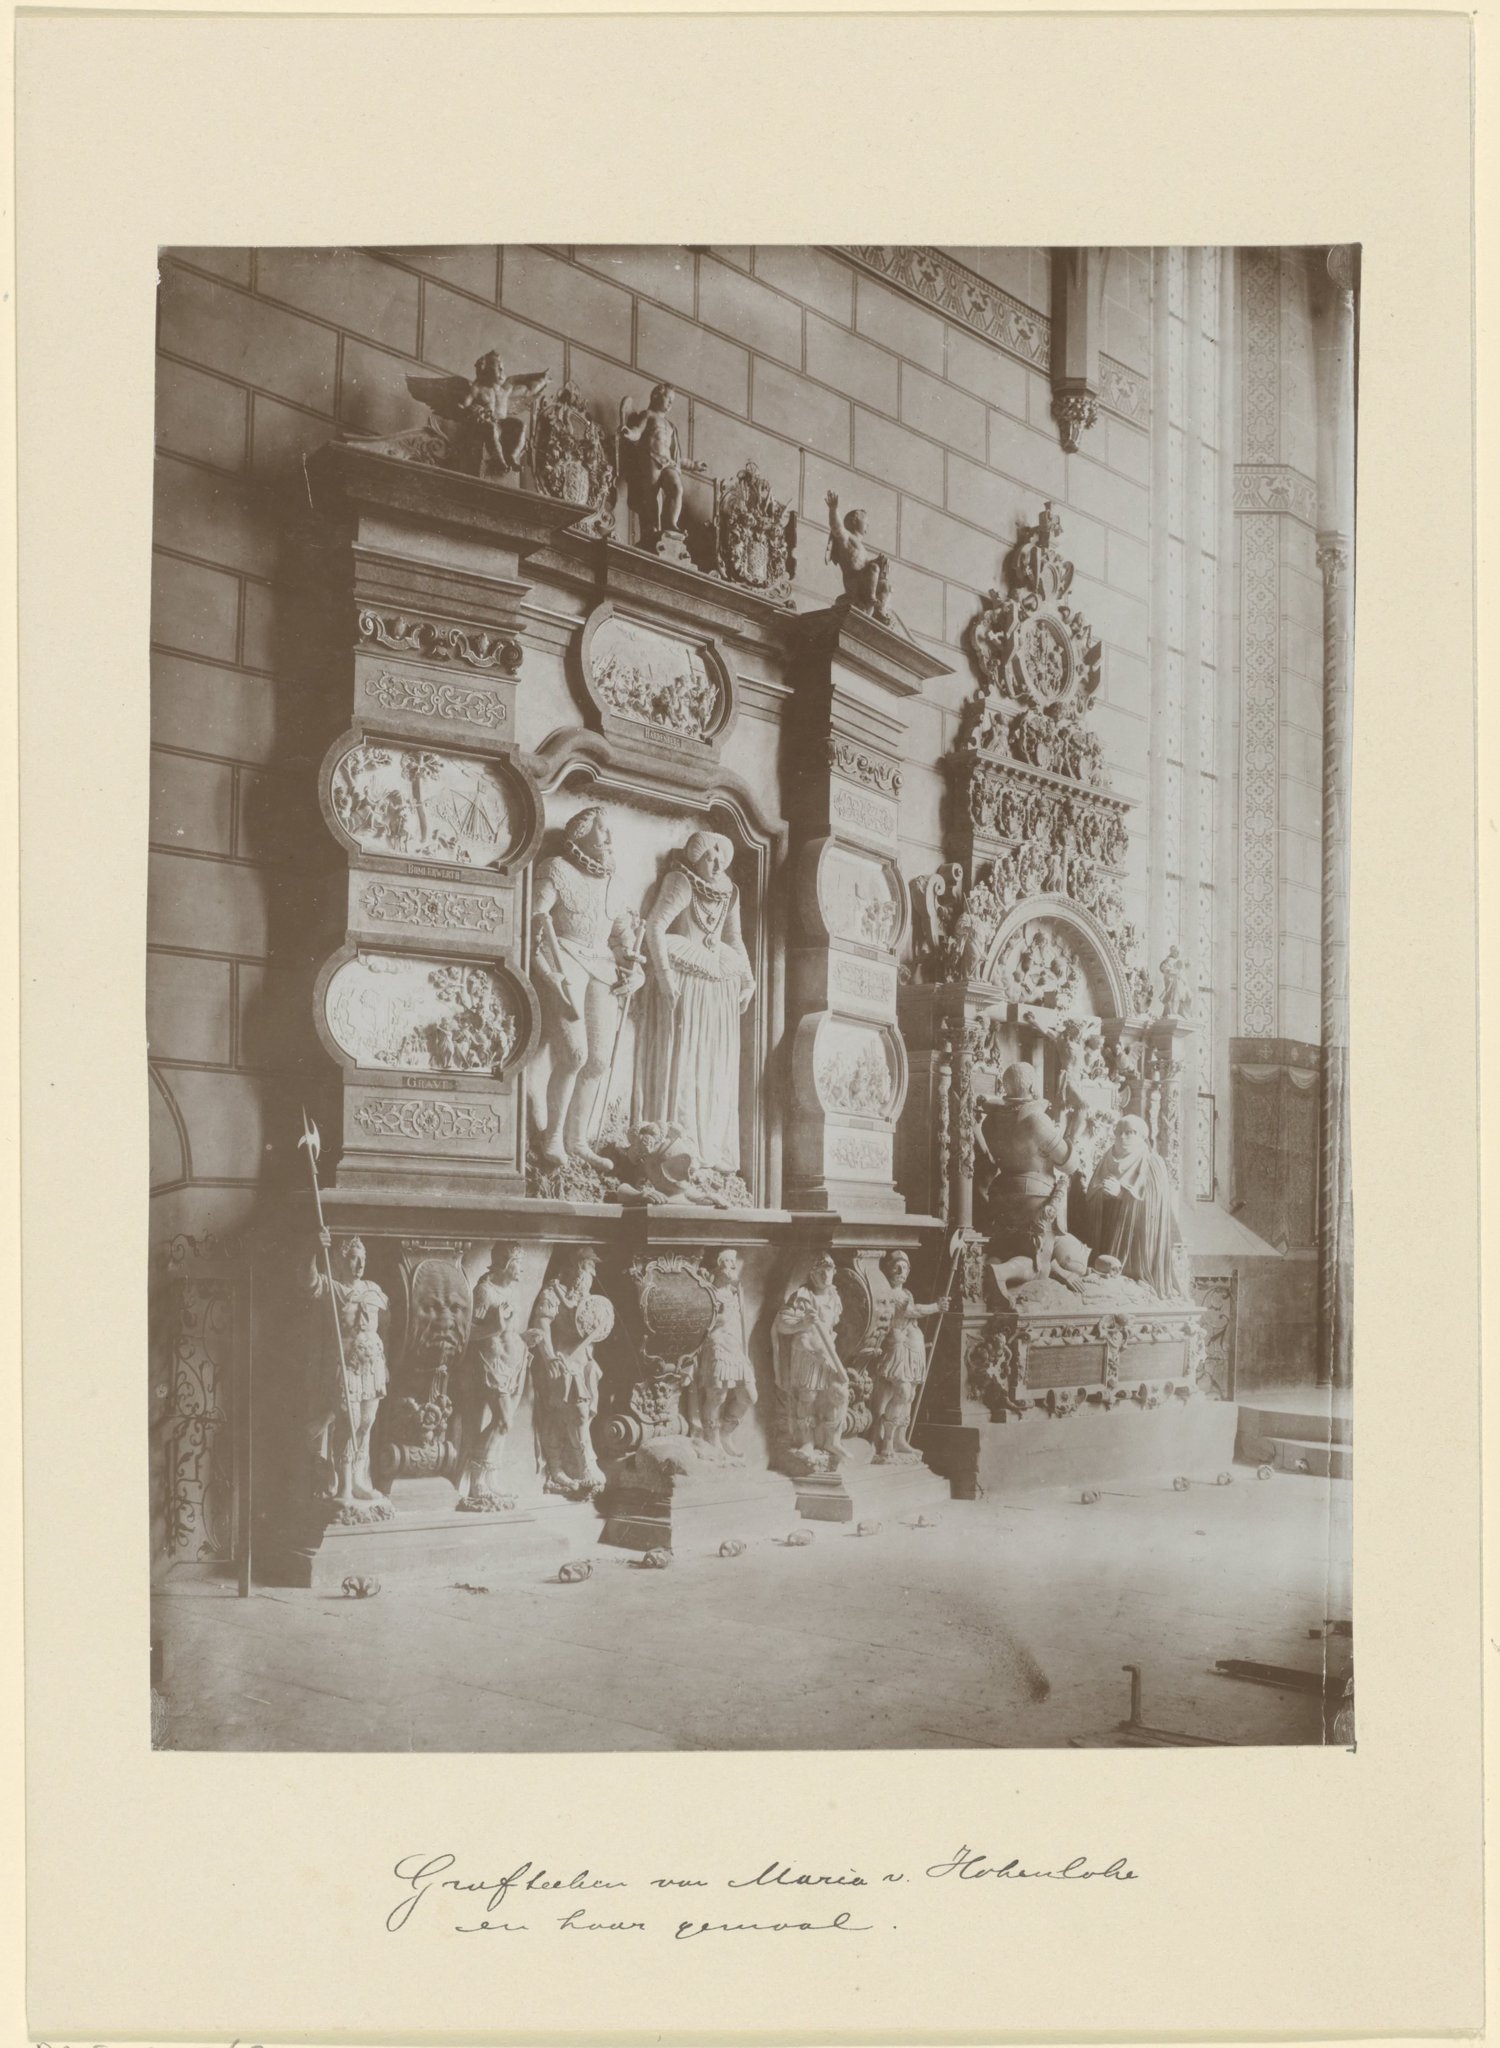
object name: photograph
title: Grafmonument voor Maria, prinses van Oranje, en Filips, graaf van Hohenlohe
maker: Anonymous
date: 1850-1930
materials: photographic support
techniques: collodion silver print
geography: netherlands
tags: buren, grave-building, monumental tomb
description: Grafmonument voor Maria en Filips in de Sint Peter en Paul Kerk te Öhringen, overleden op 5 maart 1606 en 10 oktober 1616.